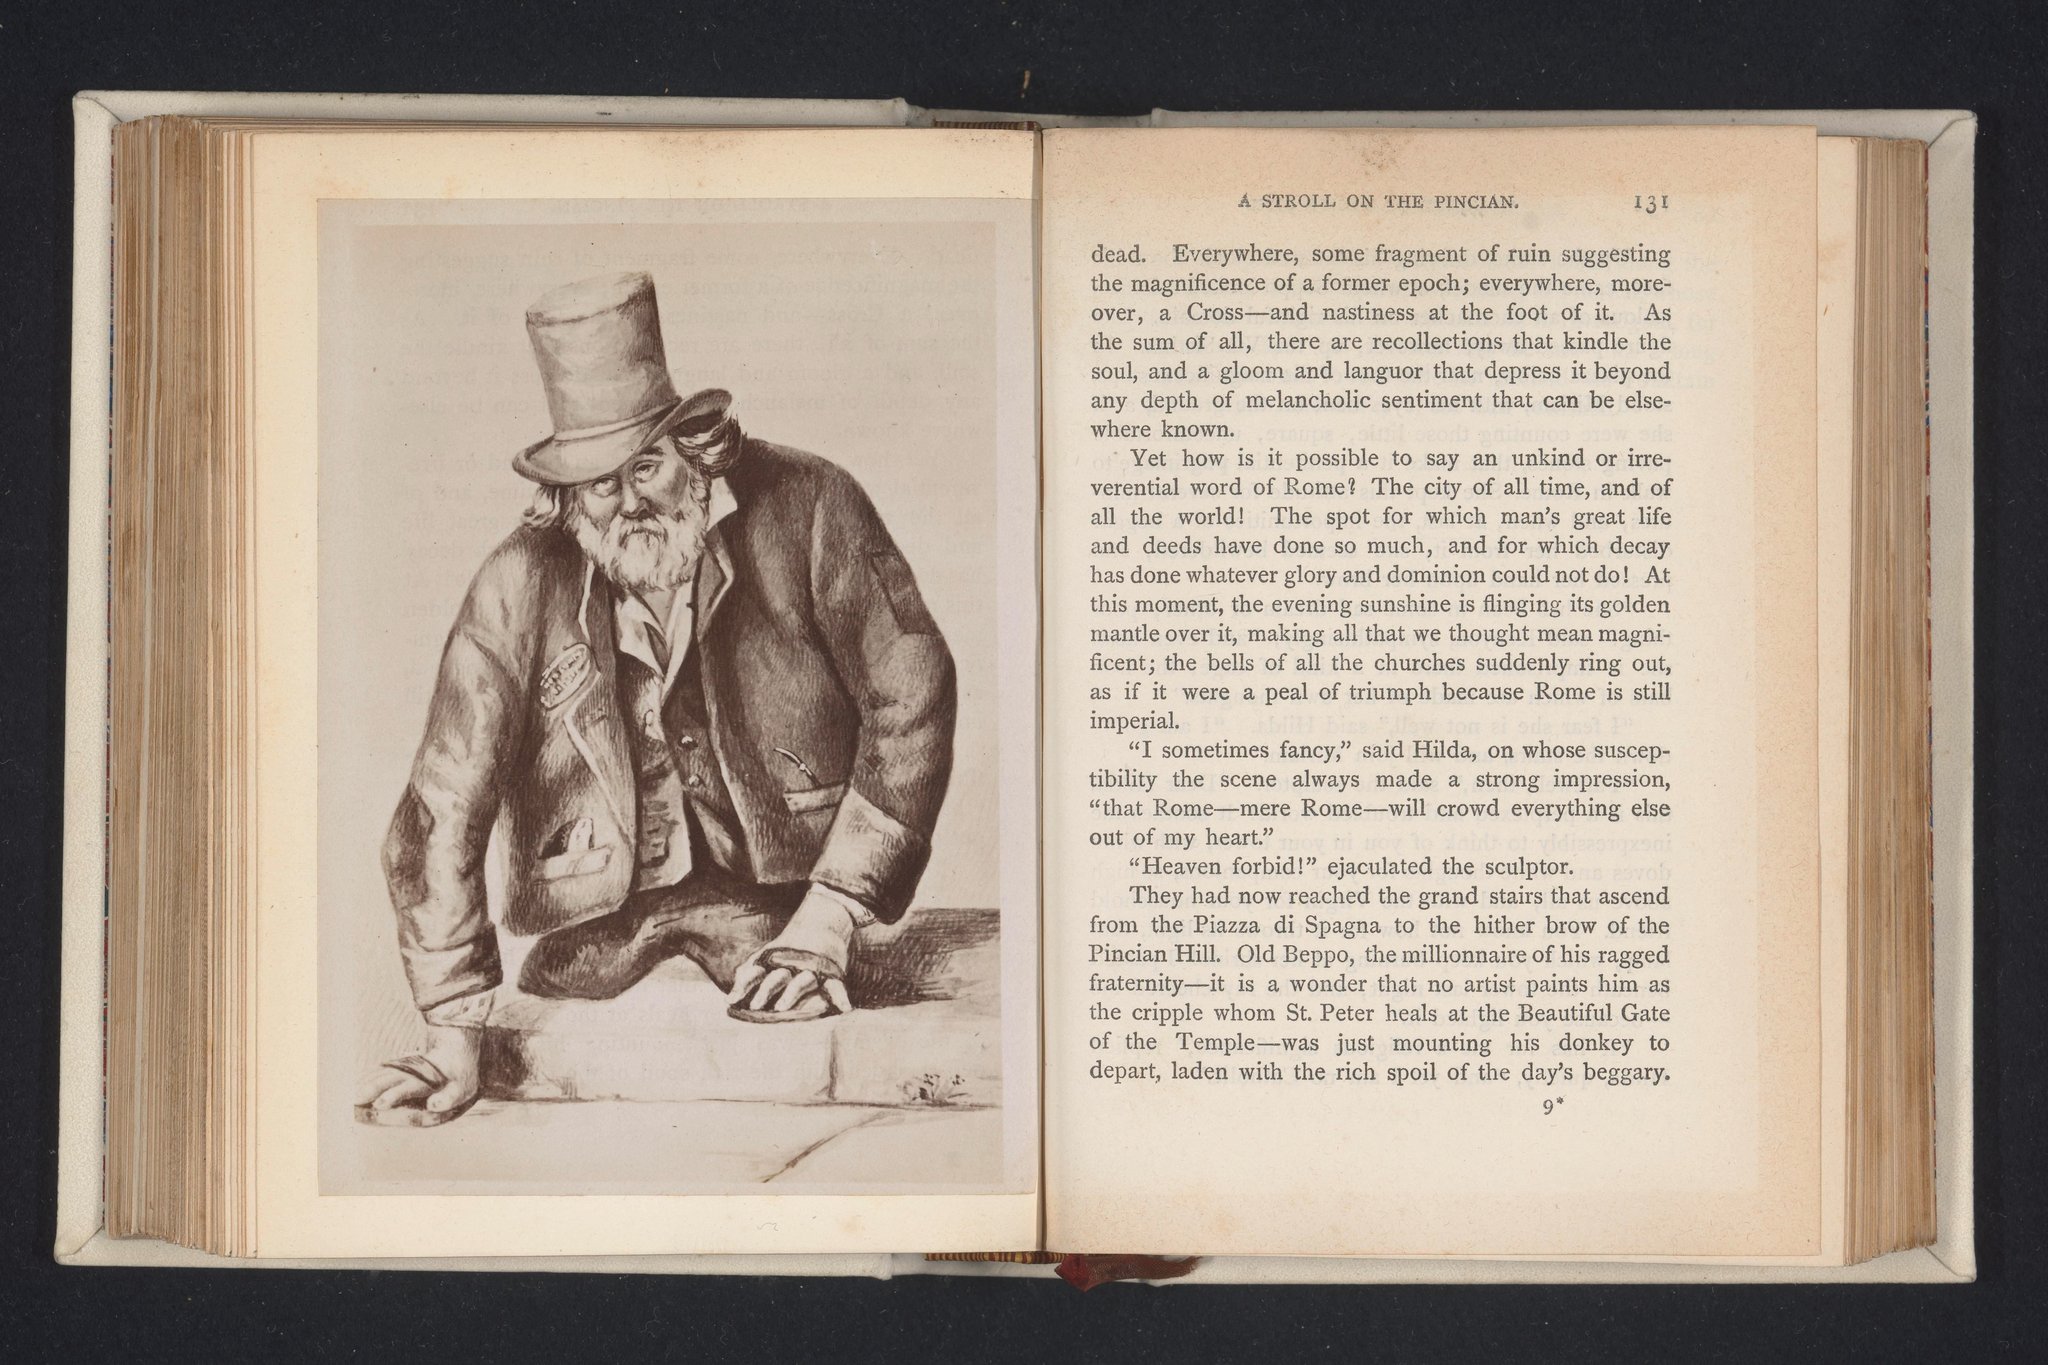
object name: page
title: Fotoreproductie van een tekening van een man zonder benen, mogelijk was zijn naam Beppo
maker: Anonymous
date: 1850-1860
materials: photographic support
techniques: albumen print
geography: italy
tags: adult man, historical persons, painting, drawing and the graphic arts